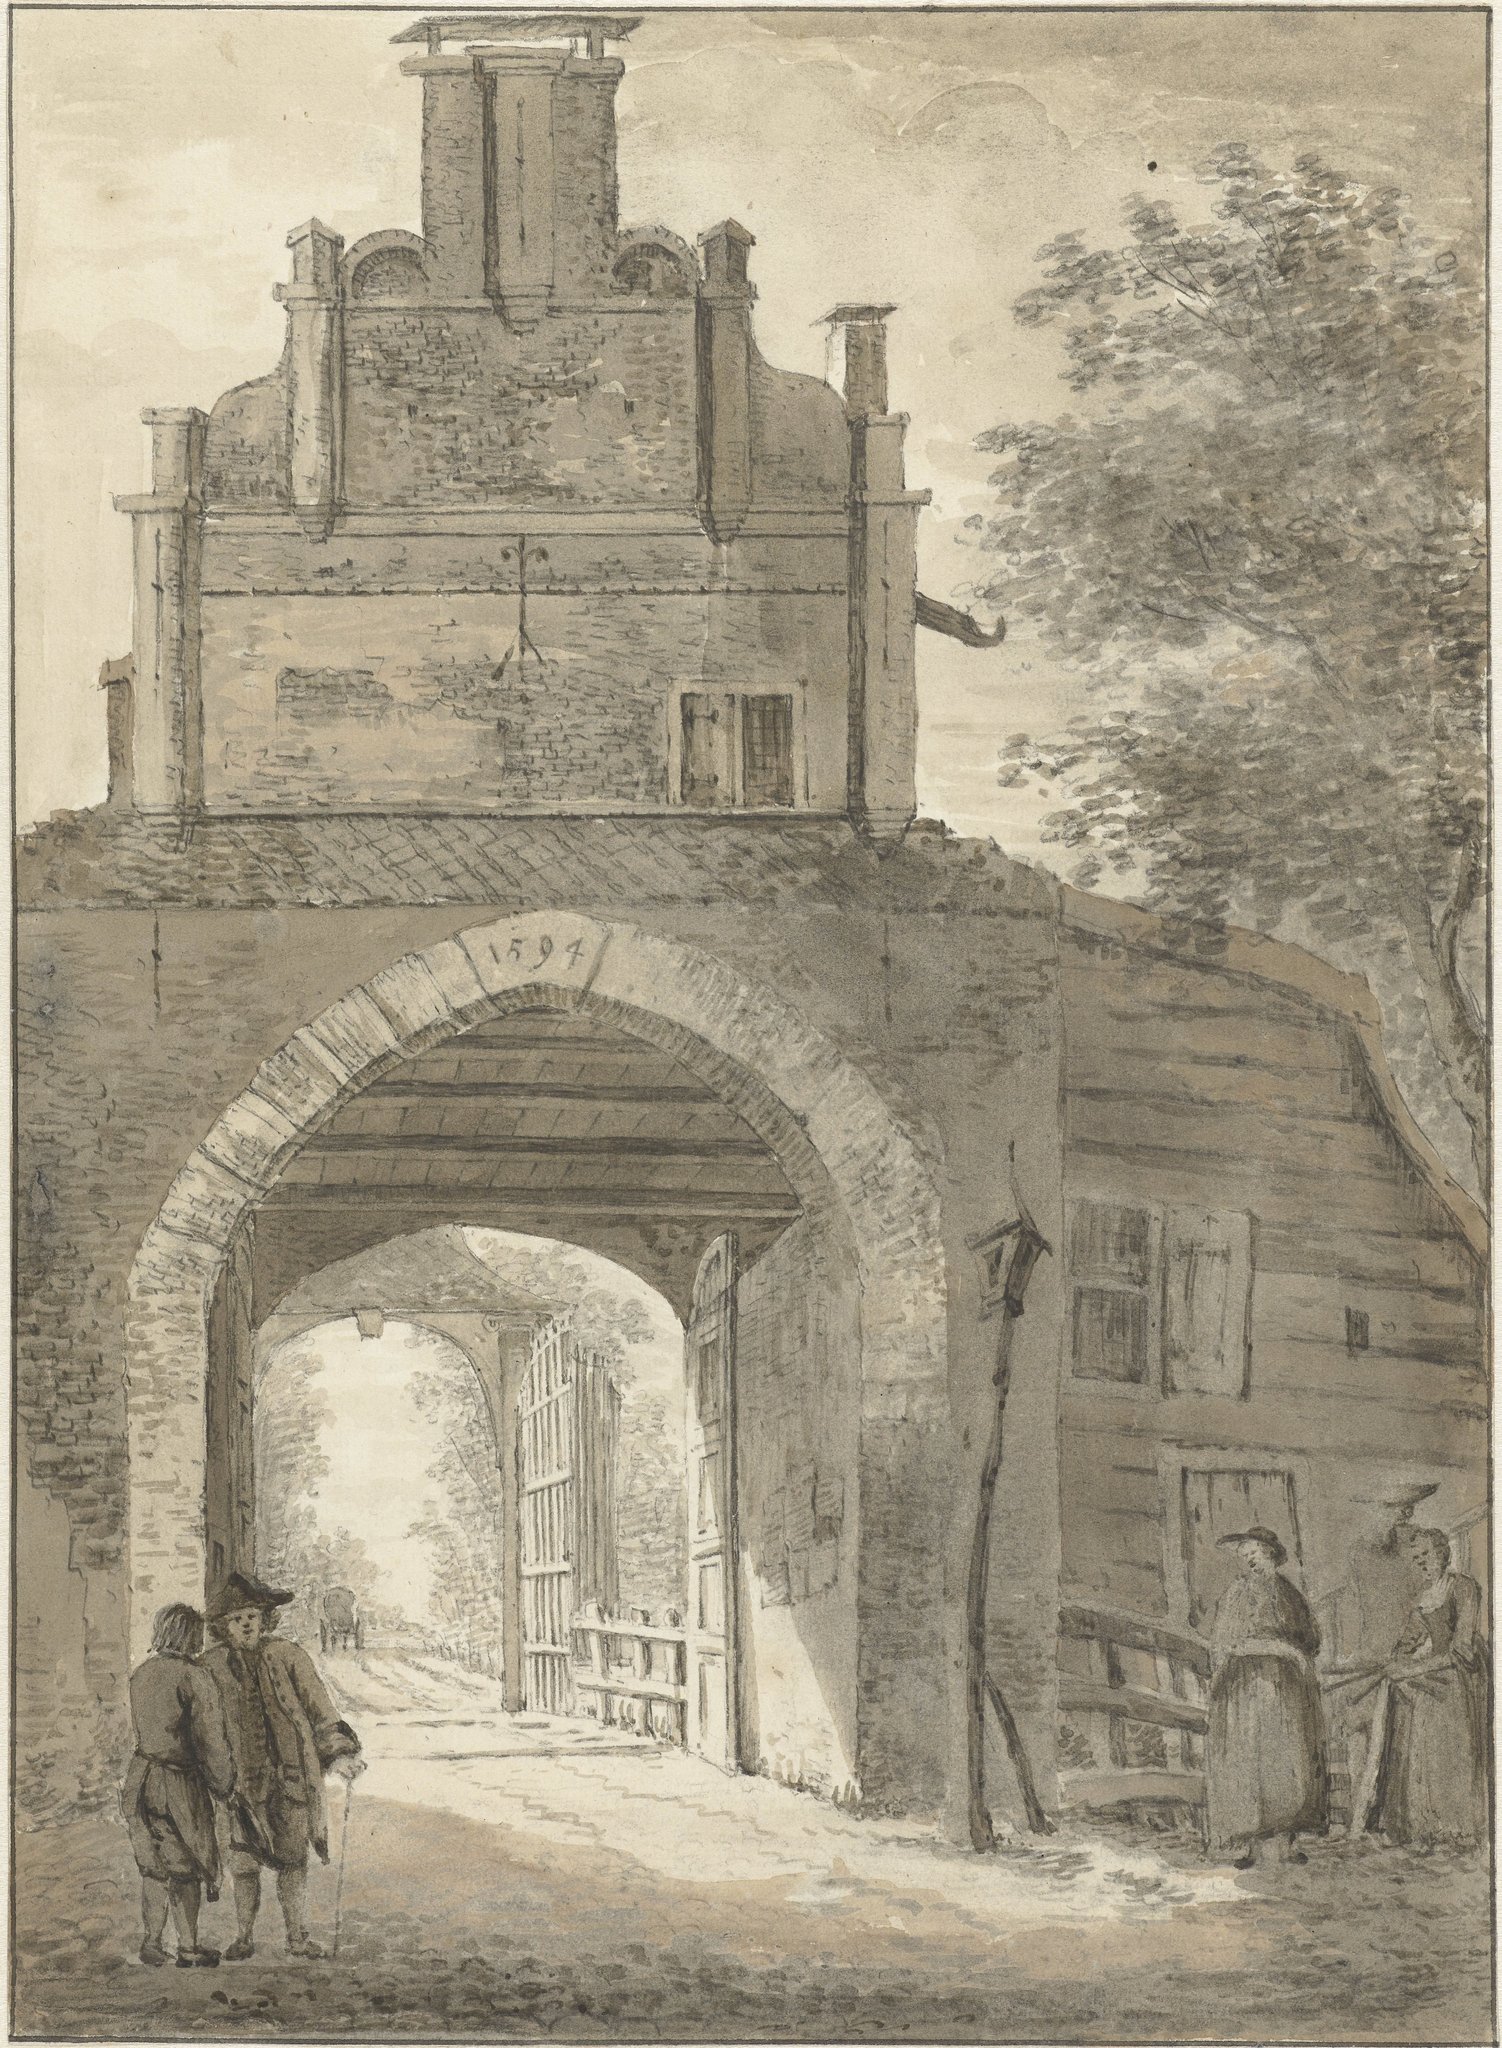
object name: drawing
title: Edammerpoort te Purmerend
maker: jacob cats (1741-1799)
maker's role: draughtsman, print maker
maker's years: 1741-1799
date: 1751-1799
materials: chalk, paper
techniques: brush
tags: city-gate